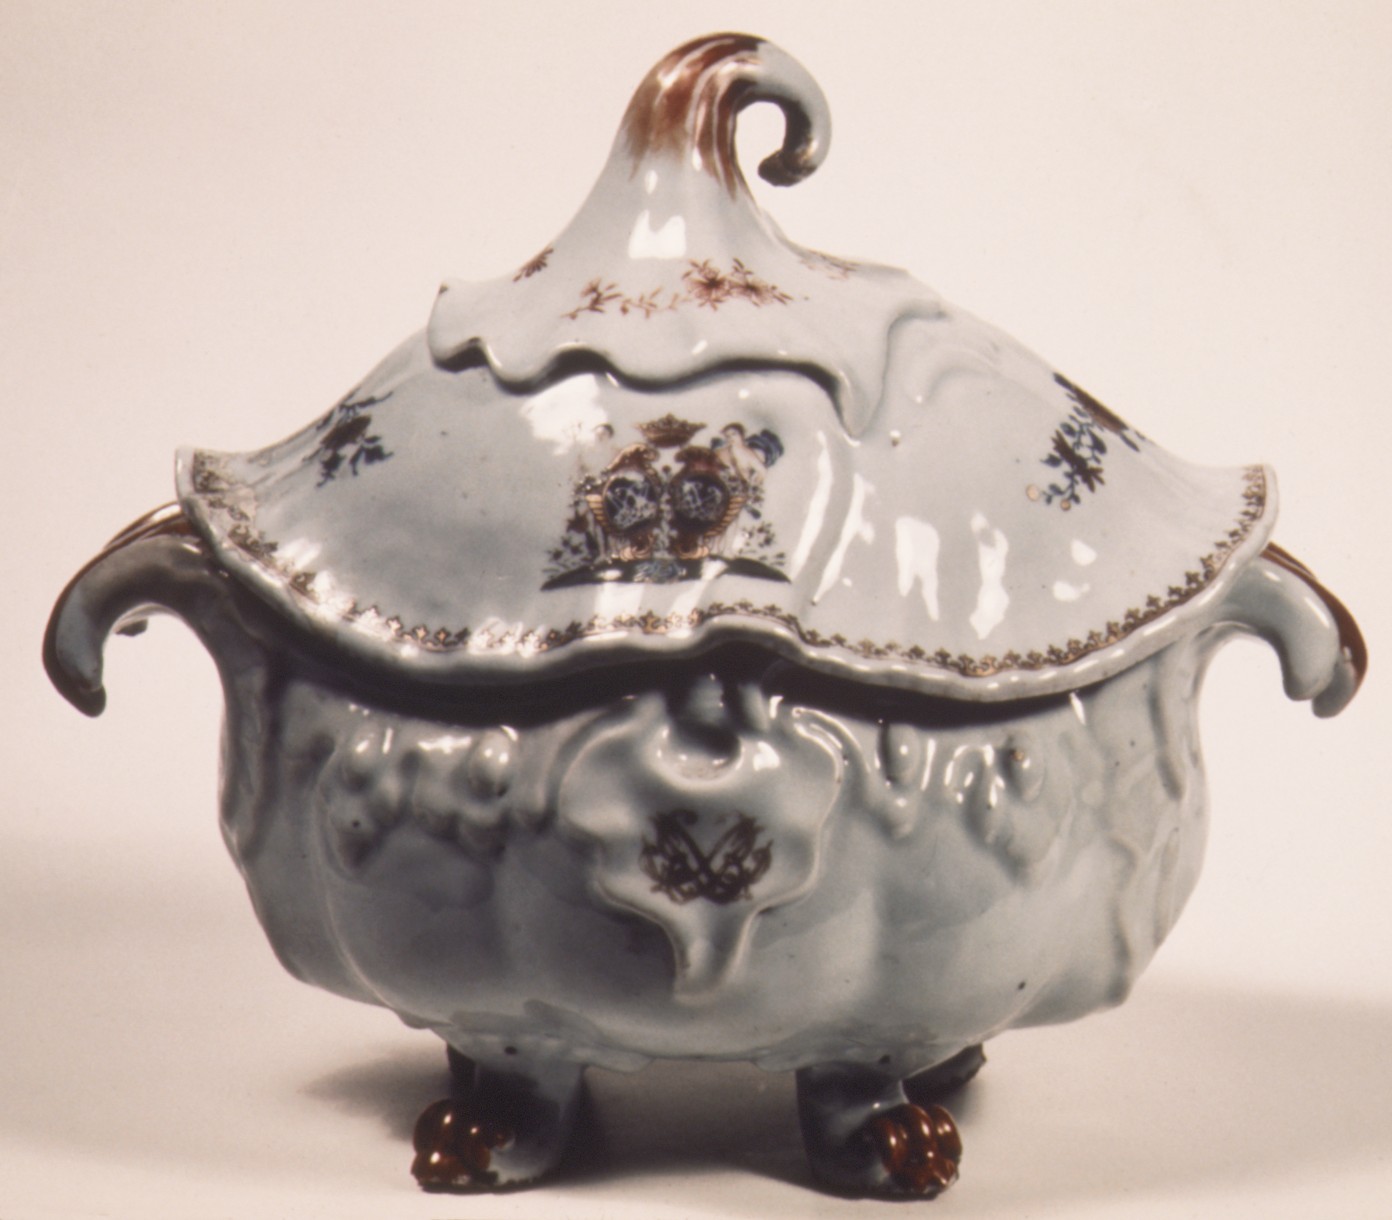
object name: tureen with cover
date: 1760-1770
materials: hard paste porcelain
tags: insignia